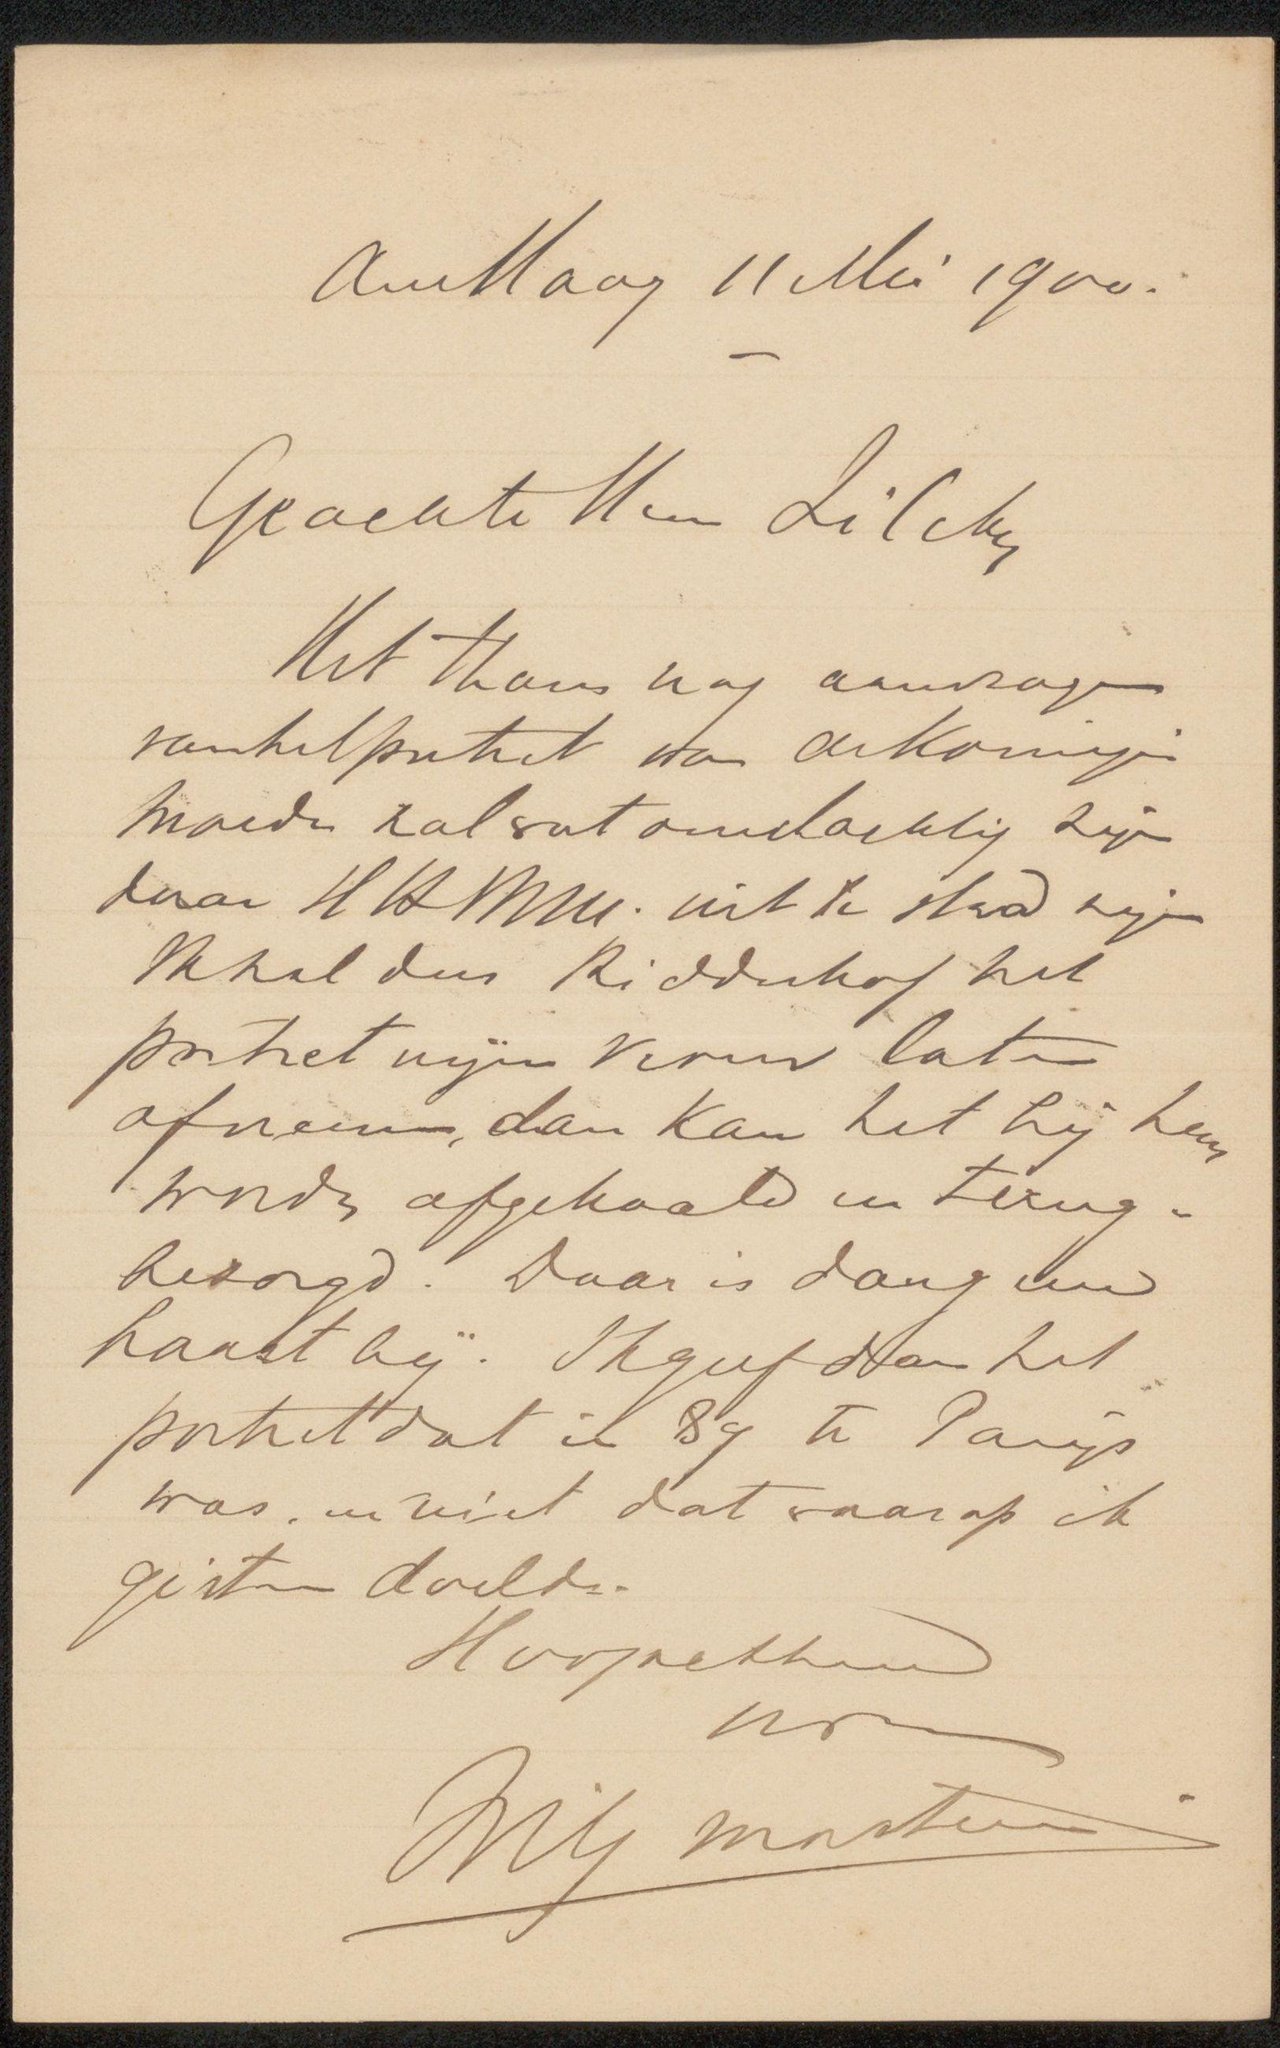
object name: letter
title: Brief aan Philip Zilcken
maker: willy martens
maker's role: painter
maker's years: 1856-1927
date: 1900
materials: ink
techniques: pen, writing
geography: the hague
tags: print maker, wilhelmina of the netherlands, the hague, painter, draughtsman, philip zilcken, historical persons (portraits and scenes from the life)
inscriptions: collector's mark: ‘RPK’